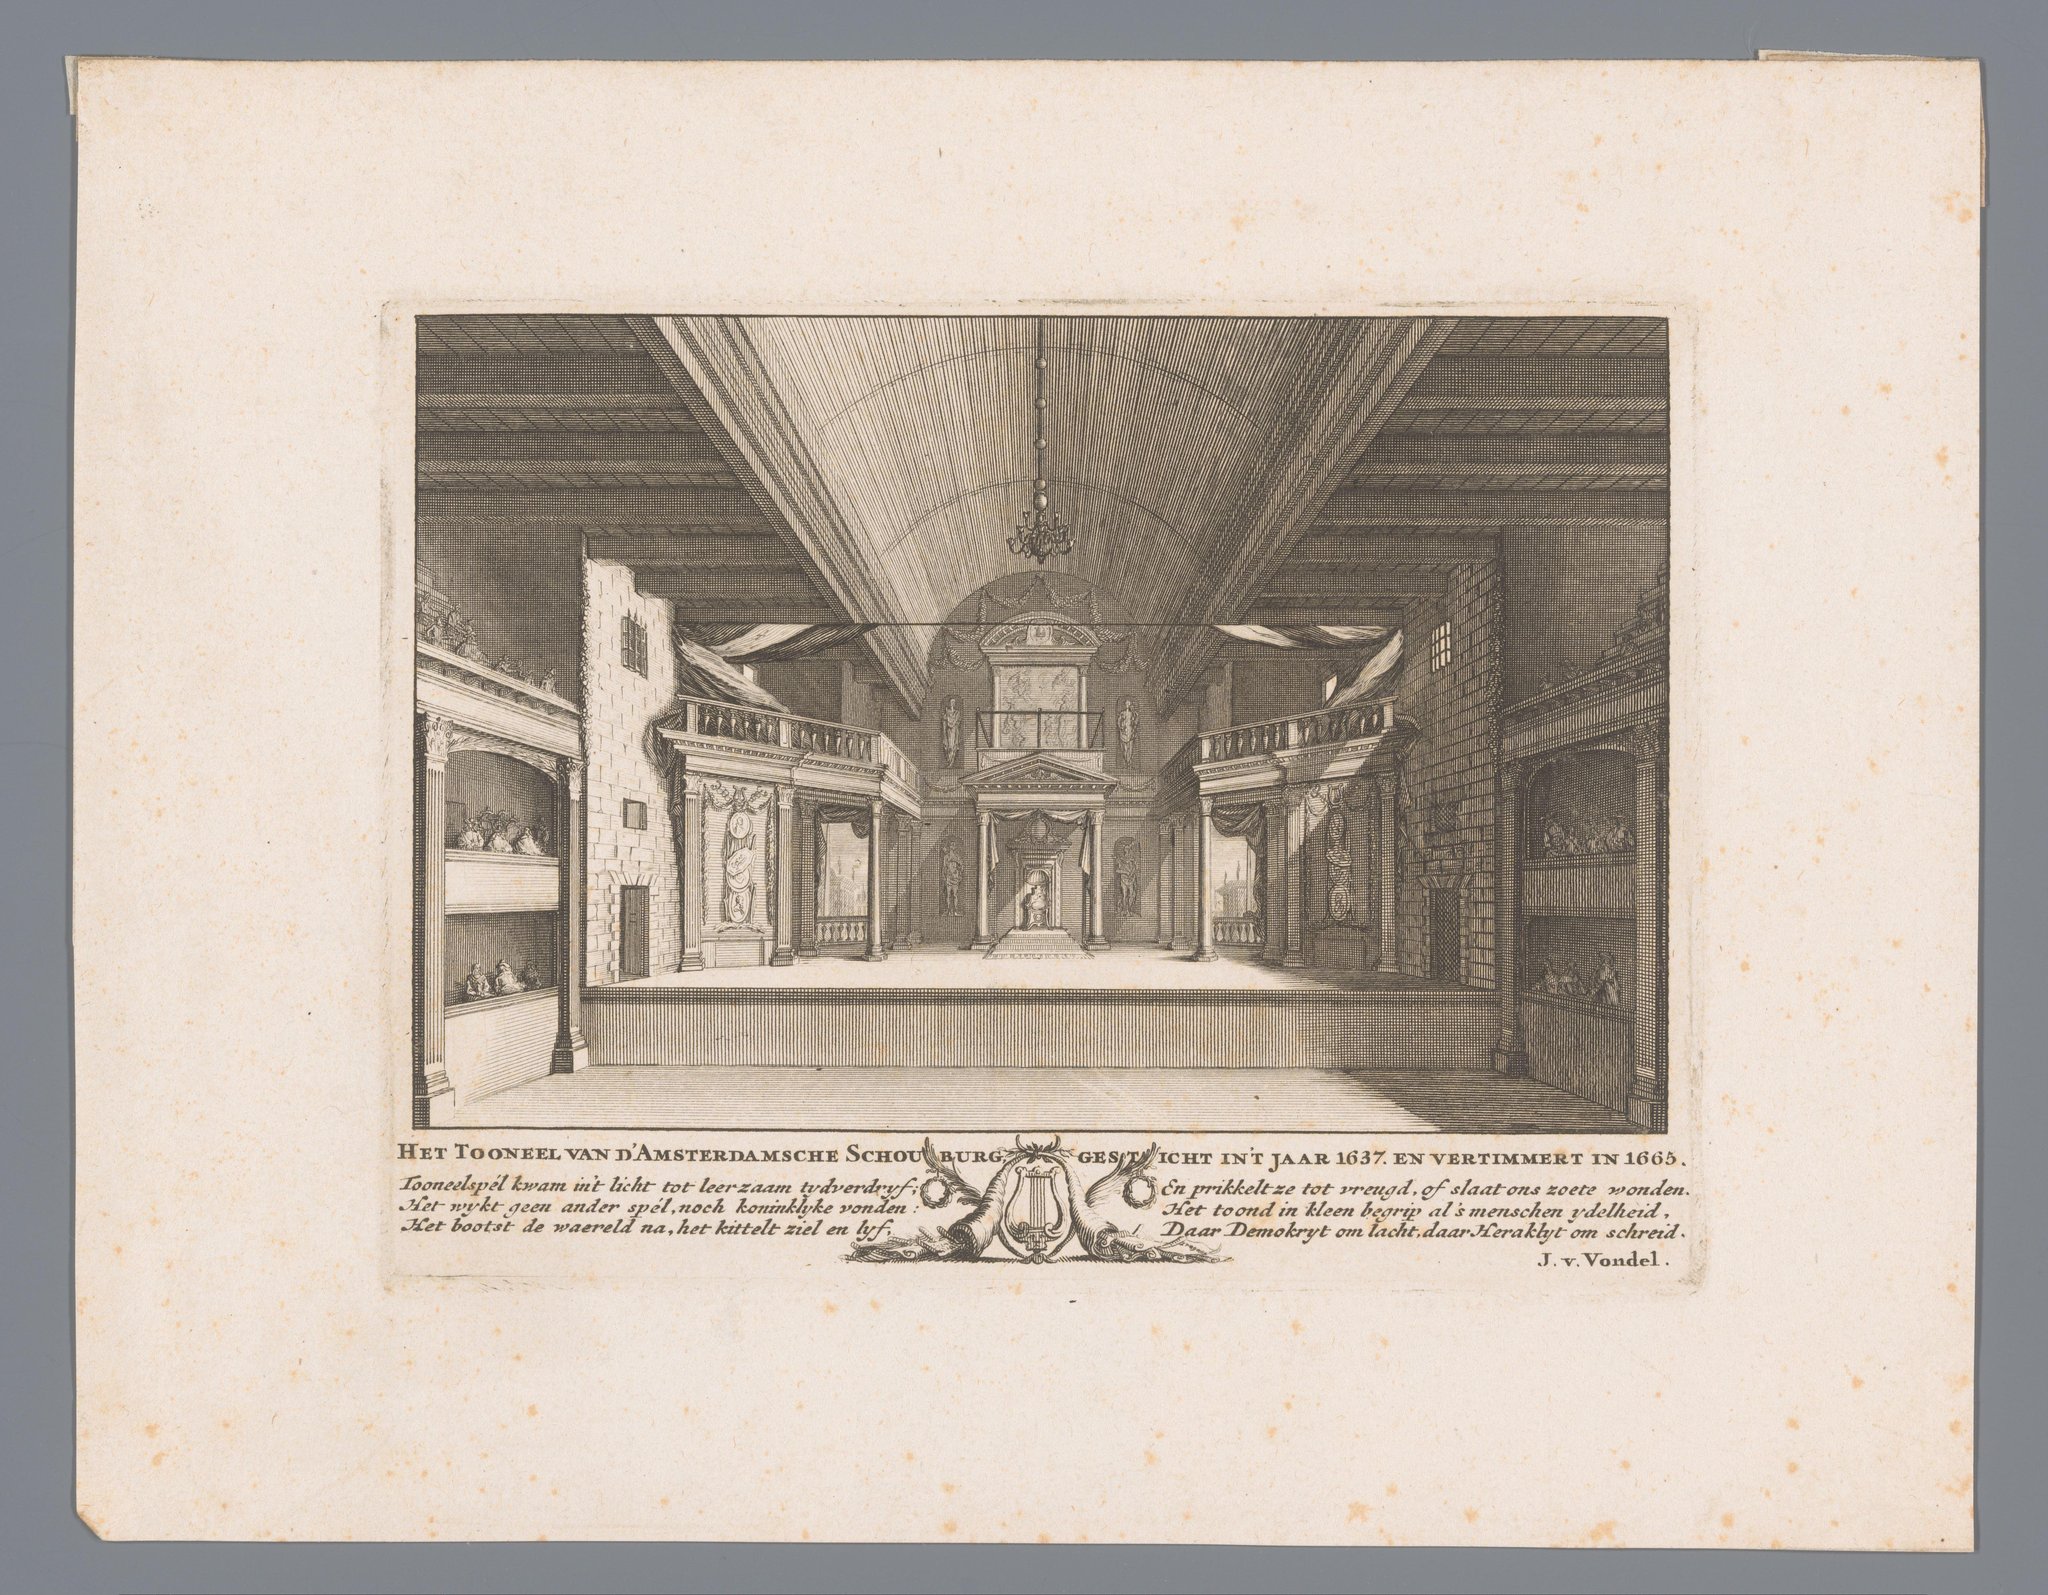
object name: print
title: Het tooneel van d'Amsterdamsche Schouburg gesticht in 't jaar 1637, en vertimmert in 1665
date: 1738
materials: paper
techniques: engraving, etching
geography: amsterdam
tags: theatre (building), the stage and its equipment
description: Prent uit: Marre, Jan de. Het eeuwgetyde van den Amsteldamschen Schouwburg (…). Amsterdam: Izaak Duim, 1738. En uit: Naamen der personaadjen, in het zinnespel het Eeuwgetyde van den Amsteldamschen schouwburg. [Amsterdam]: s.n., [1738].